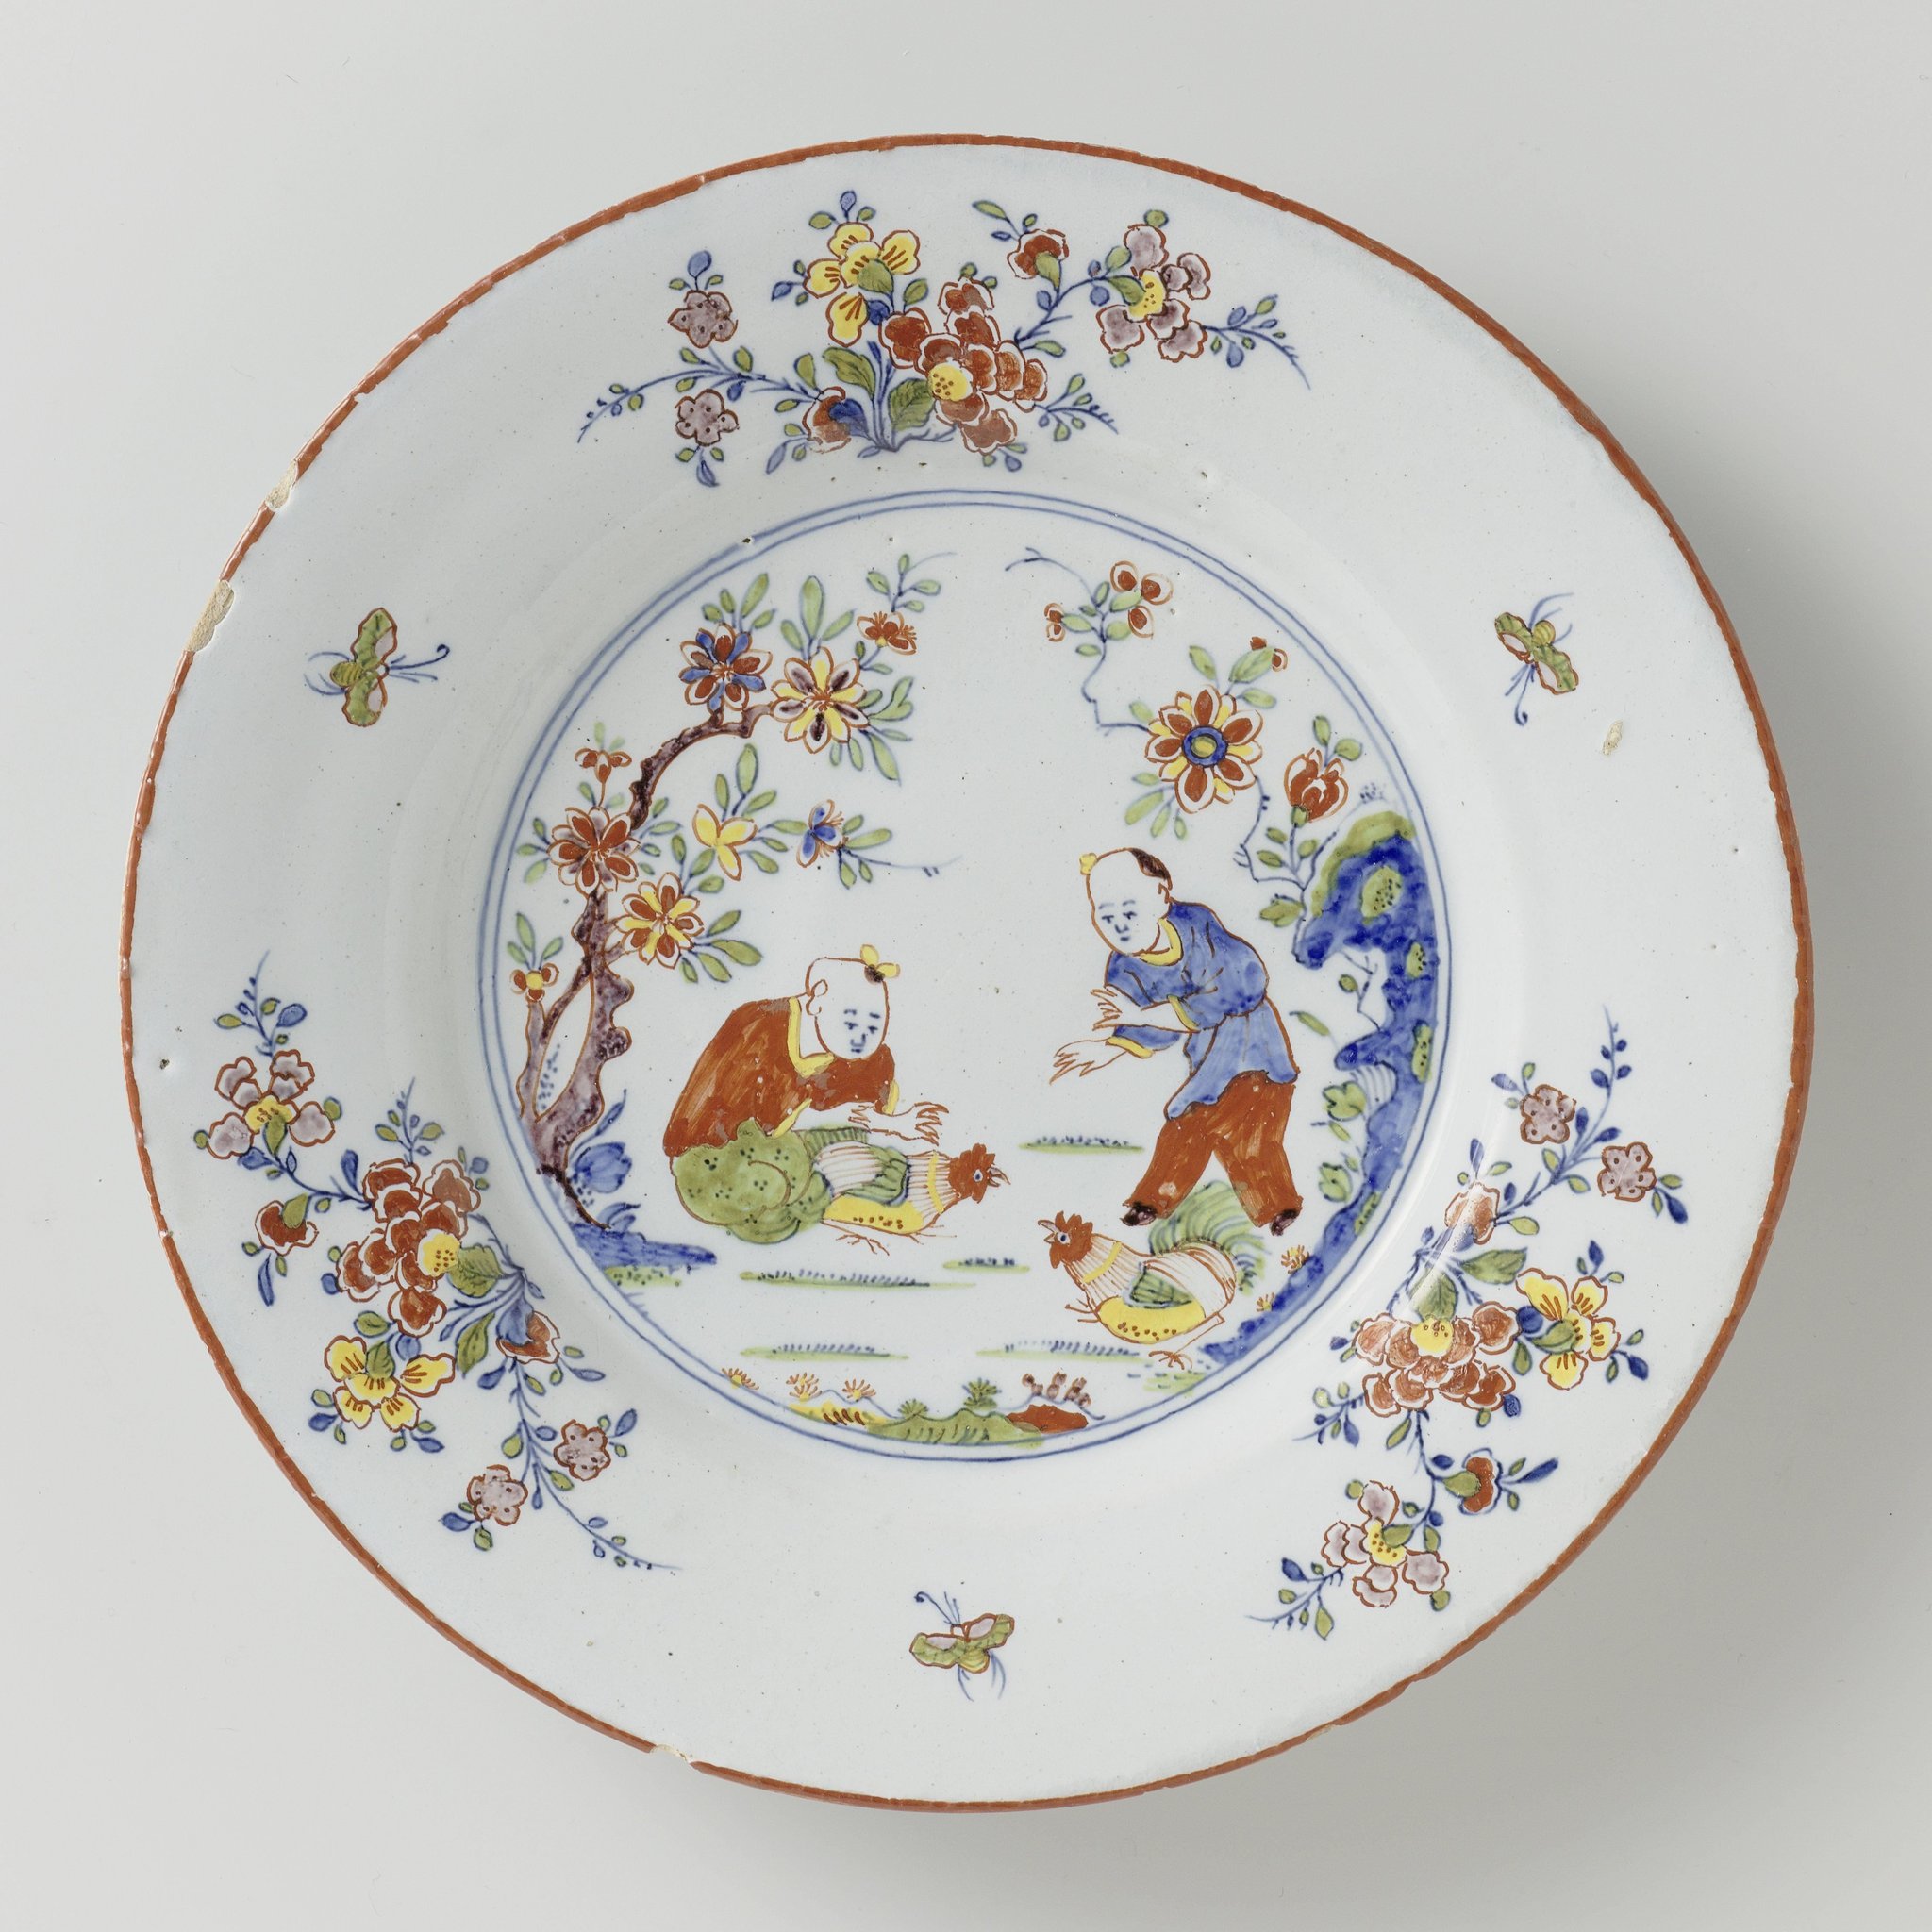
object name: plate dish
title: Bord met zogenaamde zotjes en hanen.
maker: Anonymous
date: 1740-1770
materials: earthenware, glaze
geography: delft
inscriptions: collector's mark: ‘koninklijk oudheidkundig genootschap no. 10’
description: Bord, rond, van aardewerk, aan de voor- en achterzijde met tinglazuur gedekt. Aan de voorzijde in het plat veelkleurig beschilderd met twee zotjes met hanen. Rand met drie boeketten.